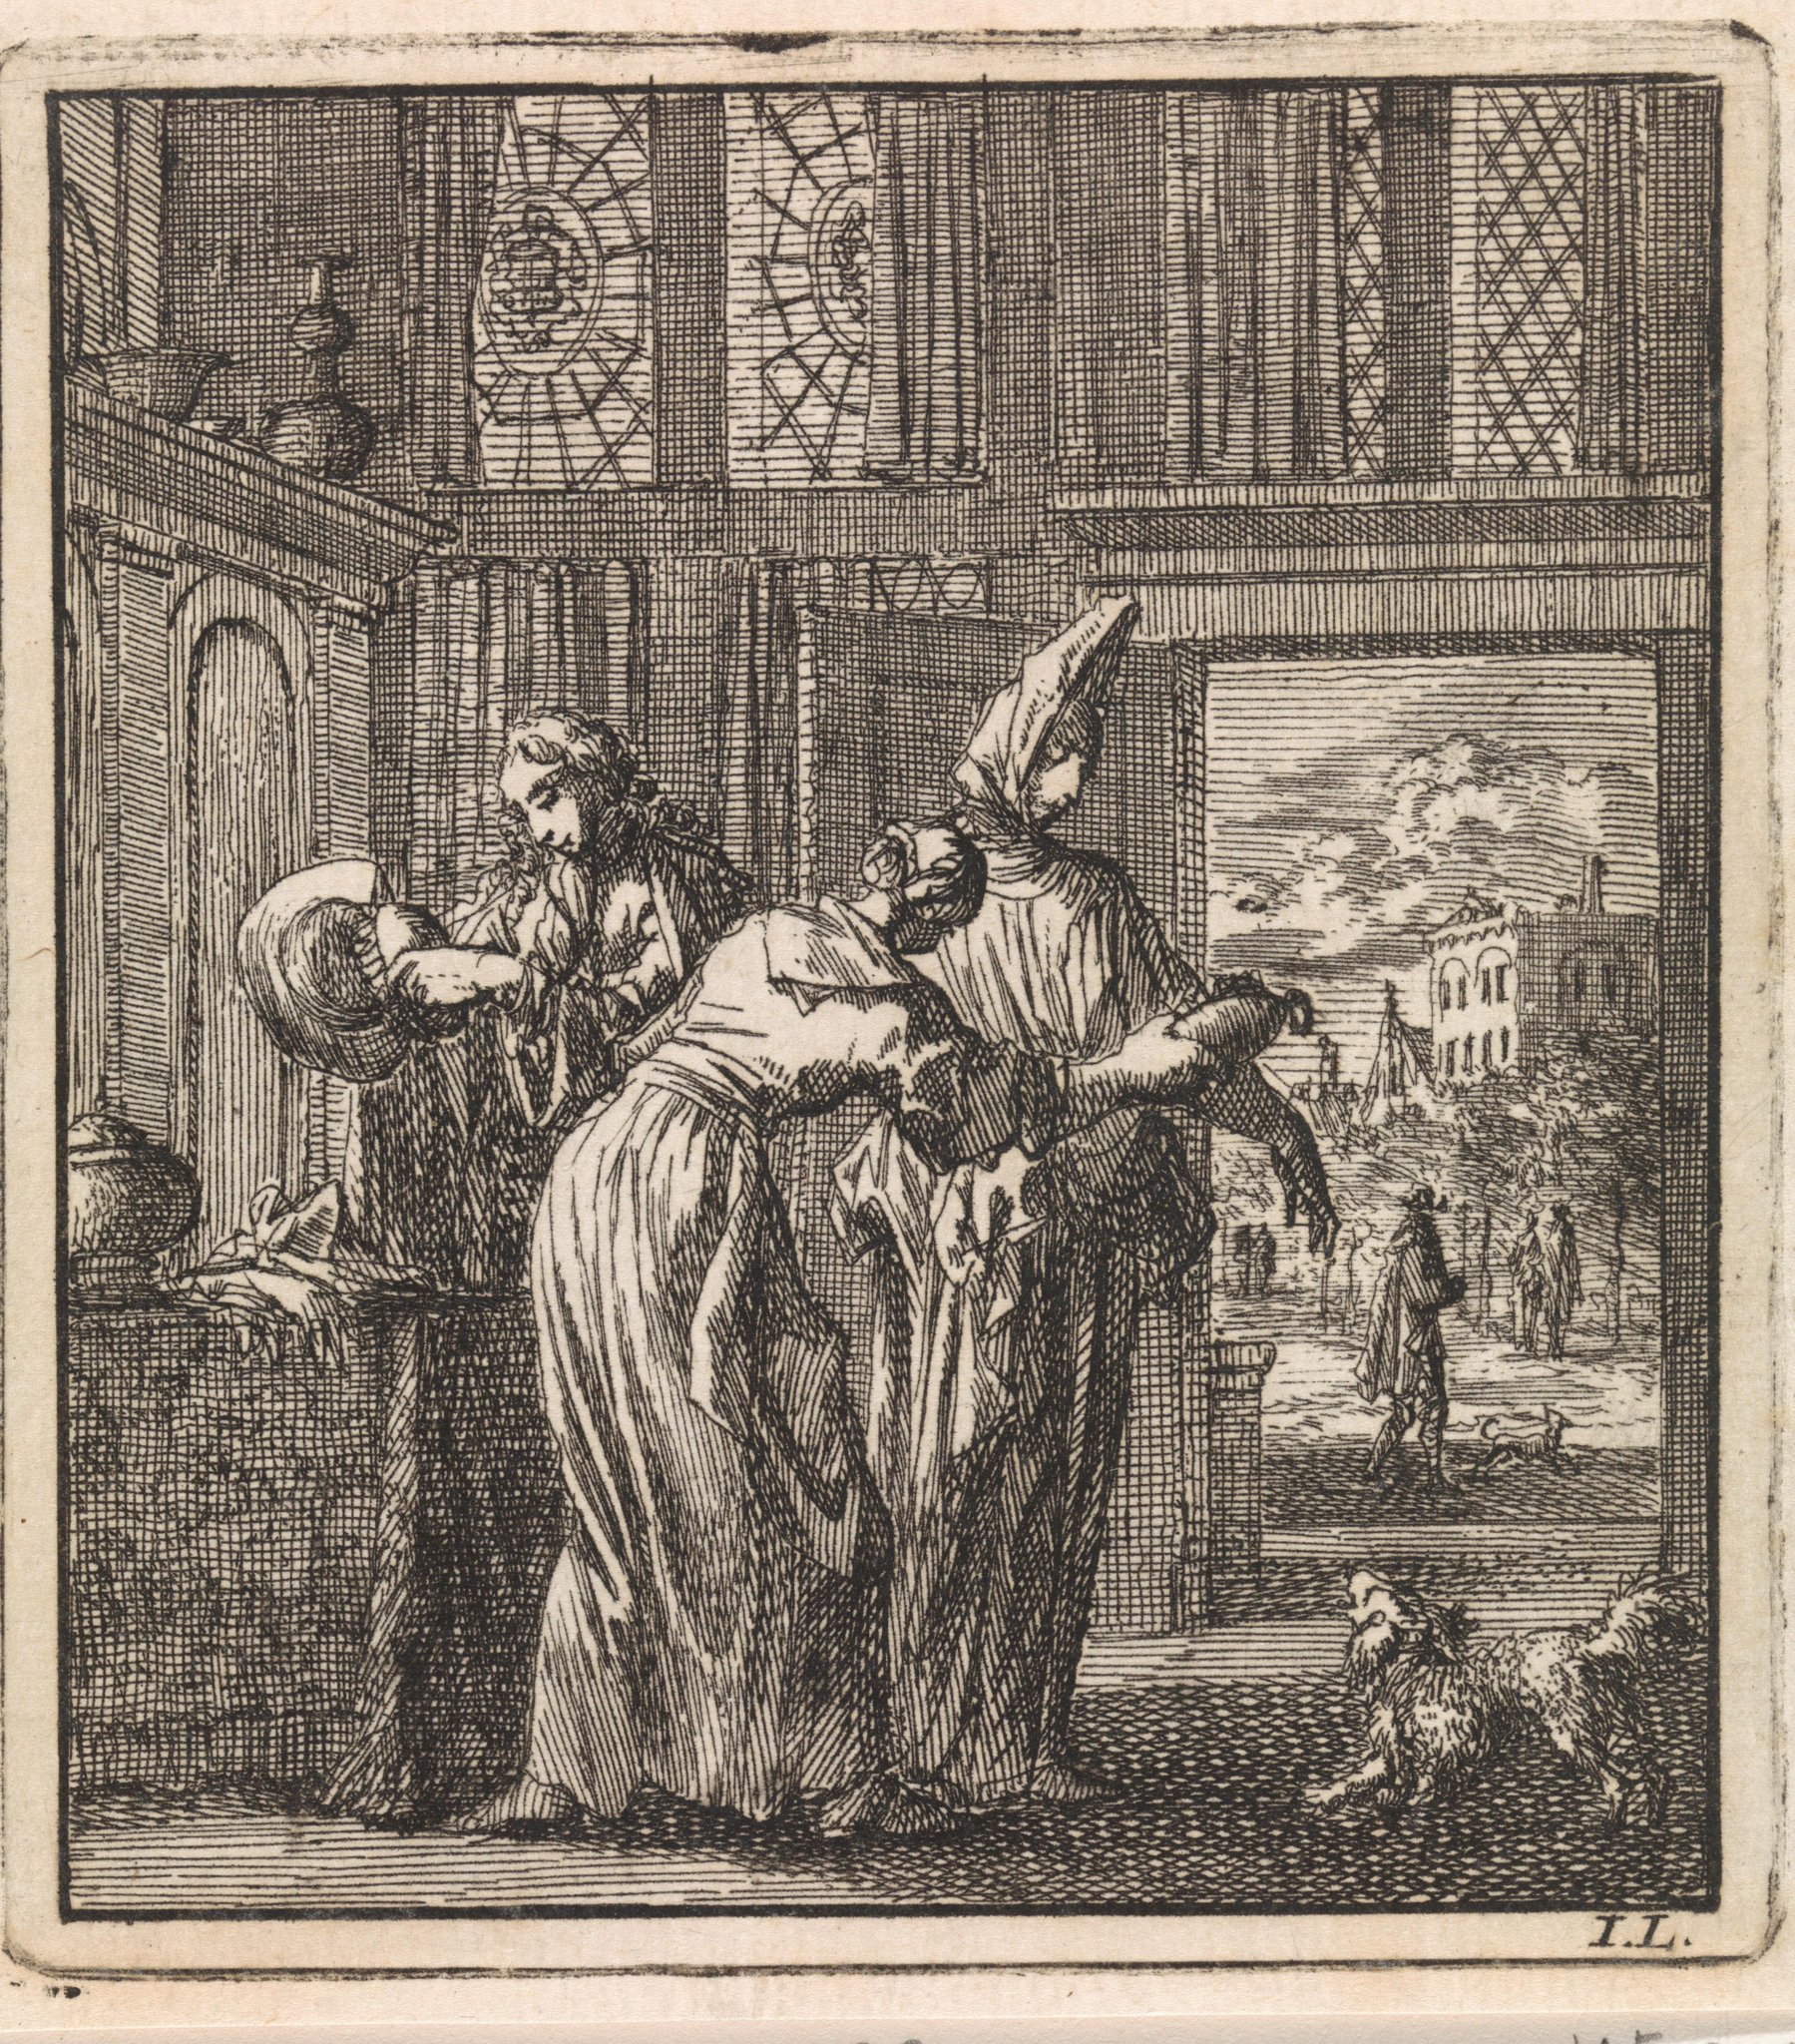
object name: print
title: Paar maakt zich klaar om uit wandelen te gaan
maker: jan luyken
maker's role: draughtsman, print maker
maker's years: 1649-1712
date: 1711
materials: paper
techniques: etching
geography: amsterdam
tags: preparations ~ travelling, dog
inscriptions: collector's mark: Lugt 2228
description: Illustratie voor: Luyken, Jan. Het leerzaam huisraad, vertoond in vyftig konstige figuuren, met godlyke spreuken en stichtelyke verzen: Pieter Arentsz. II (wed.) en Cornelis van der Sys, 1711, p. 58.